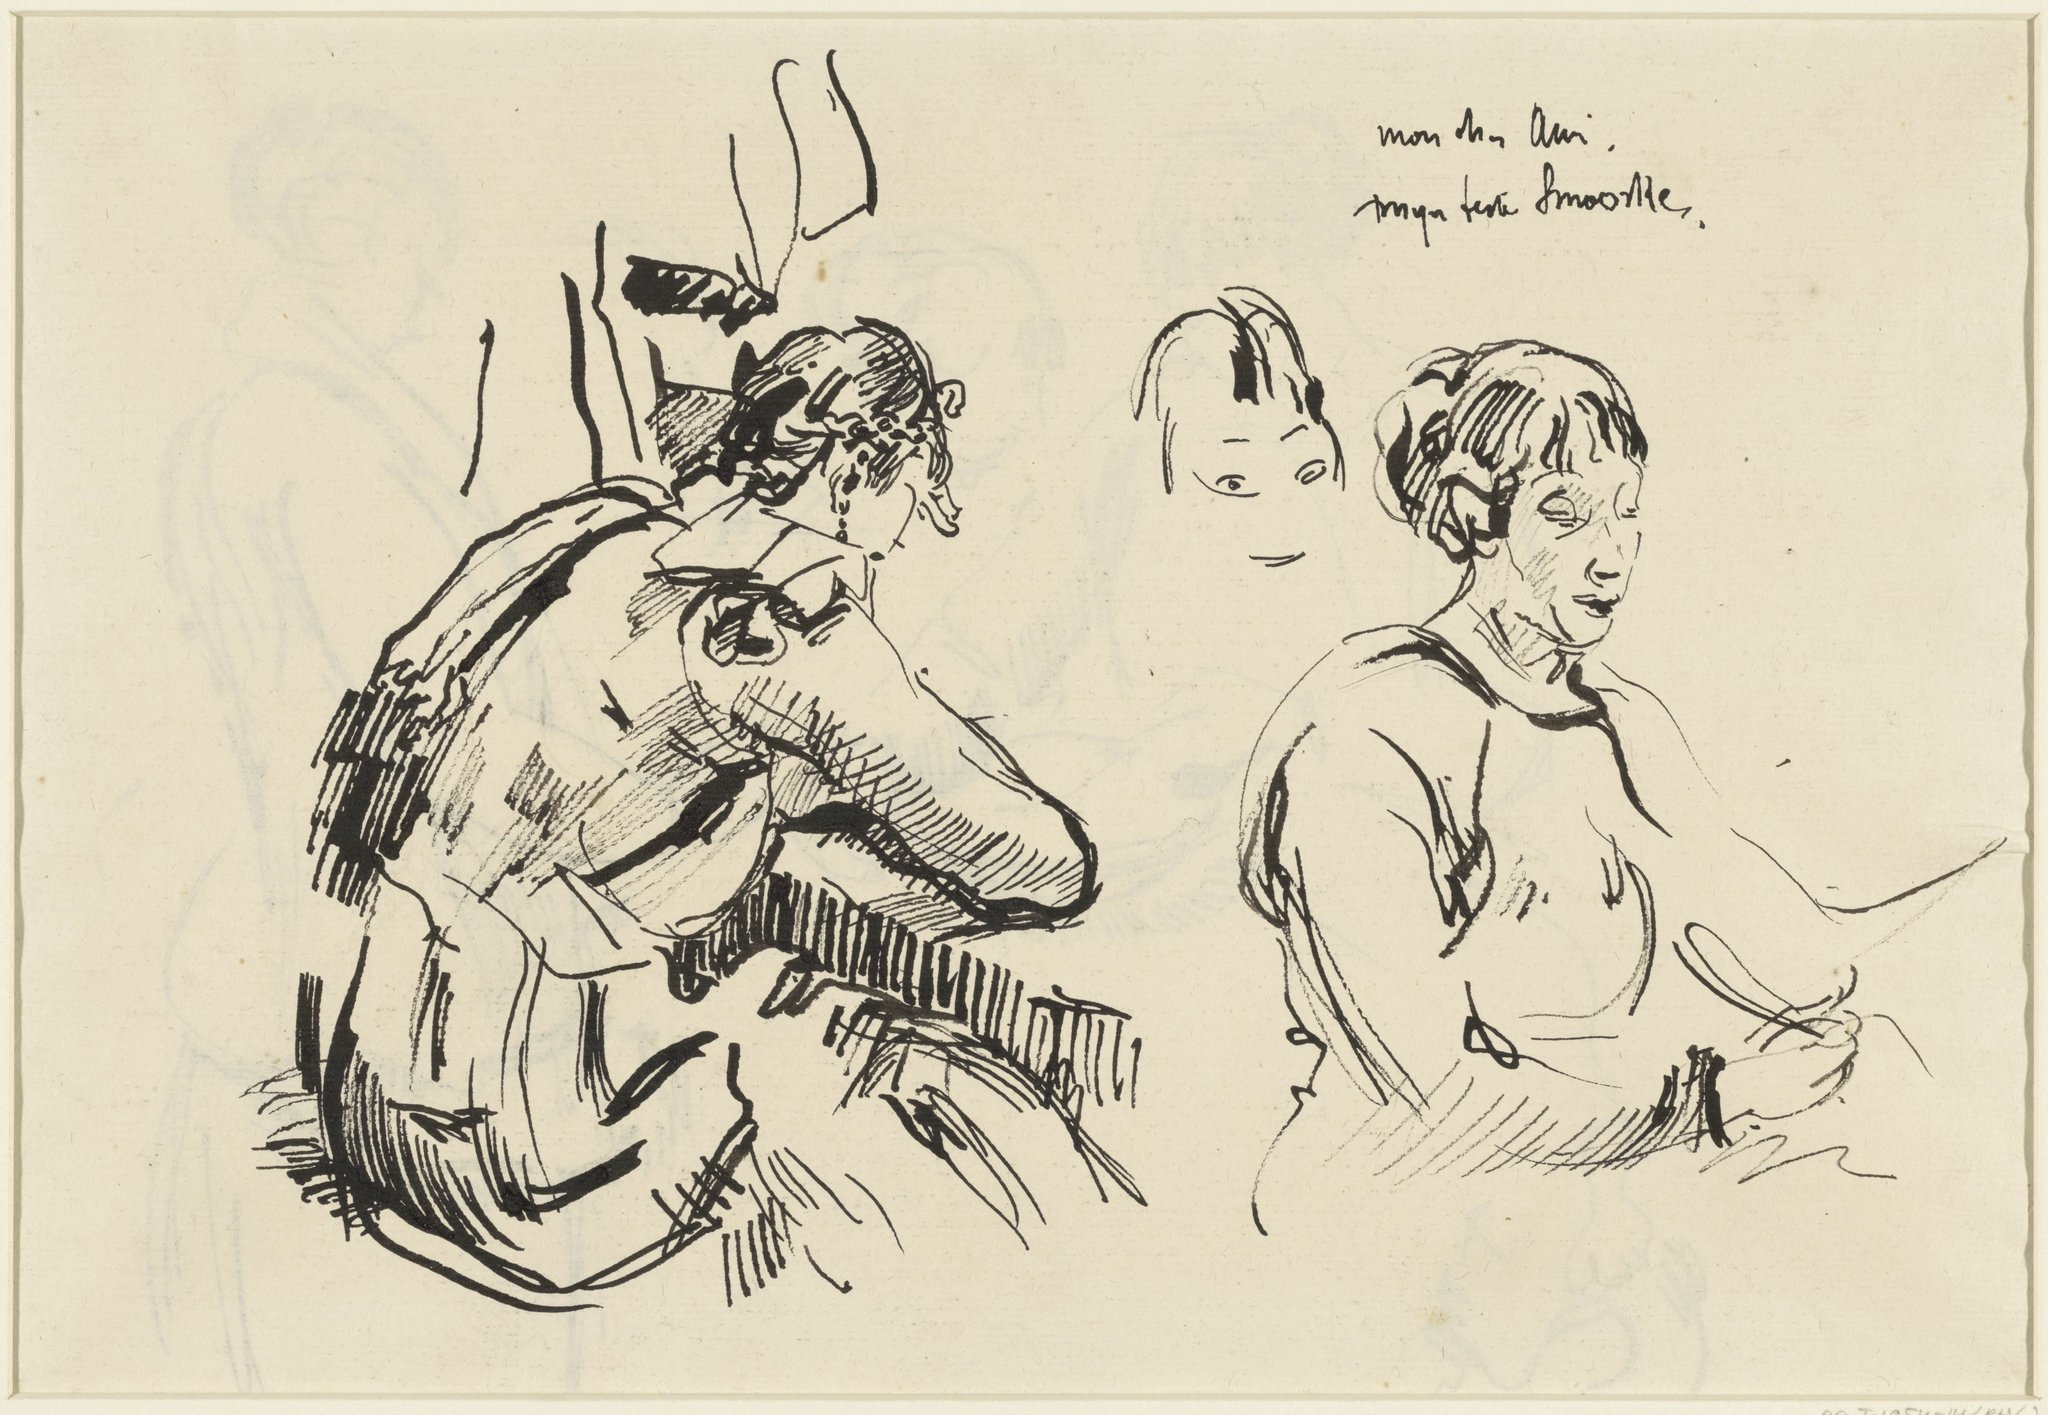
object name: drawing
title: Studies van een vrouw die een brief schrijft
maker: rik wouters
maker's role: draughtsman, print maker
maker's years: 1882-1916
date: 1892-1916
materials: ink, paper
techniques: pen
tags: handwriting, writing as activity